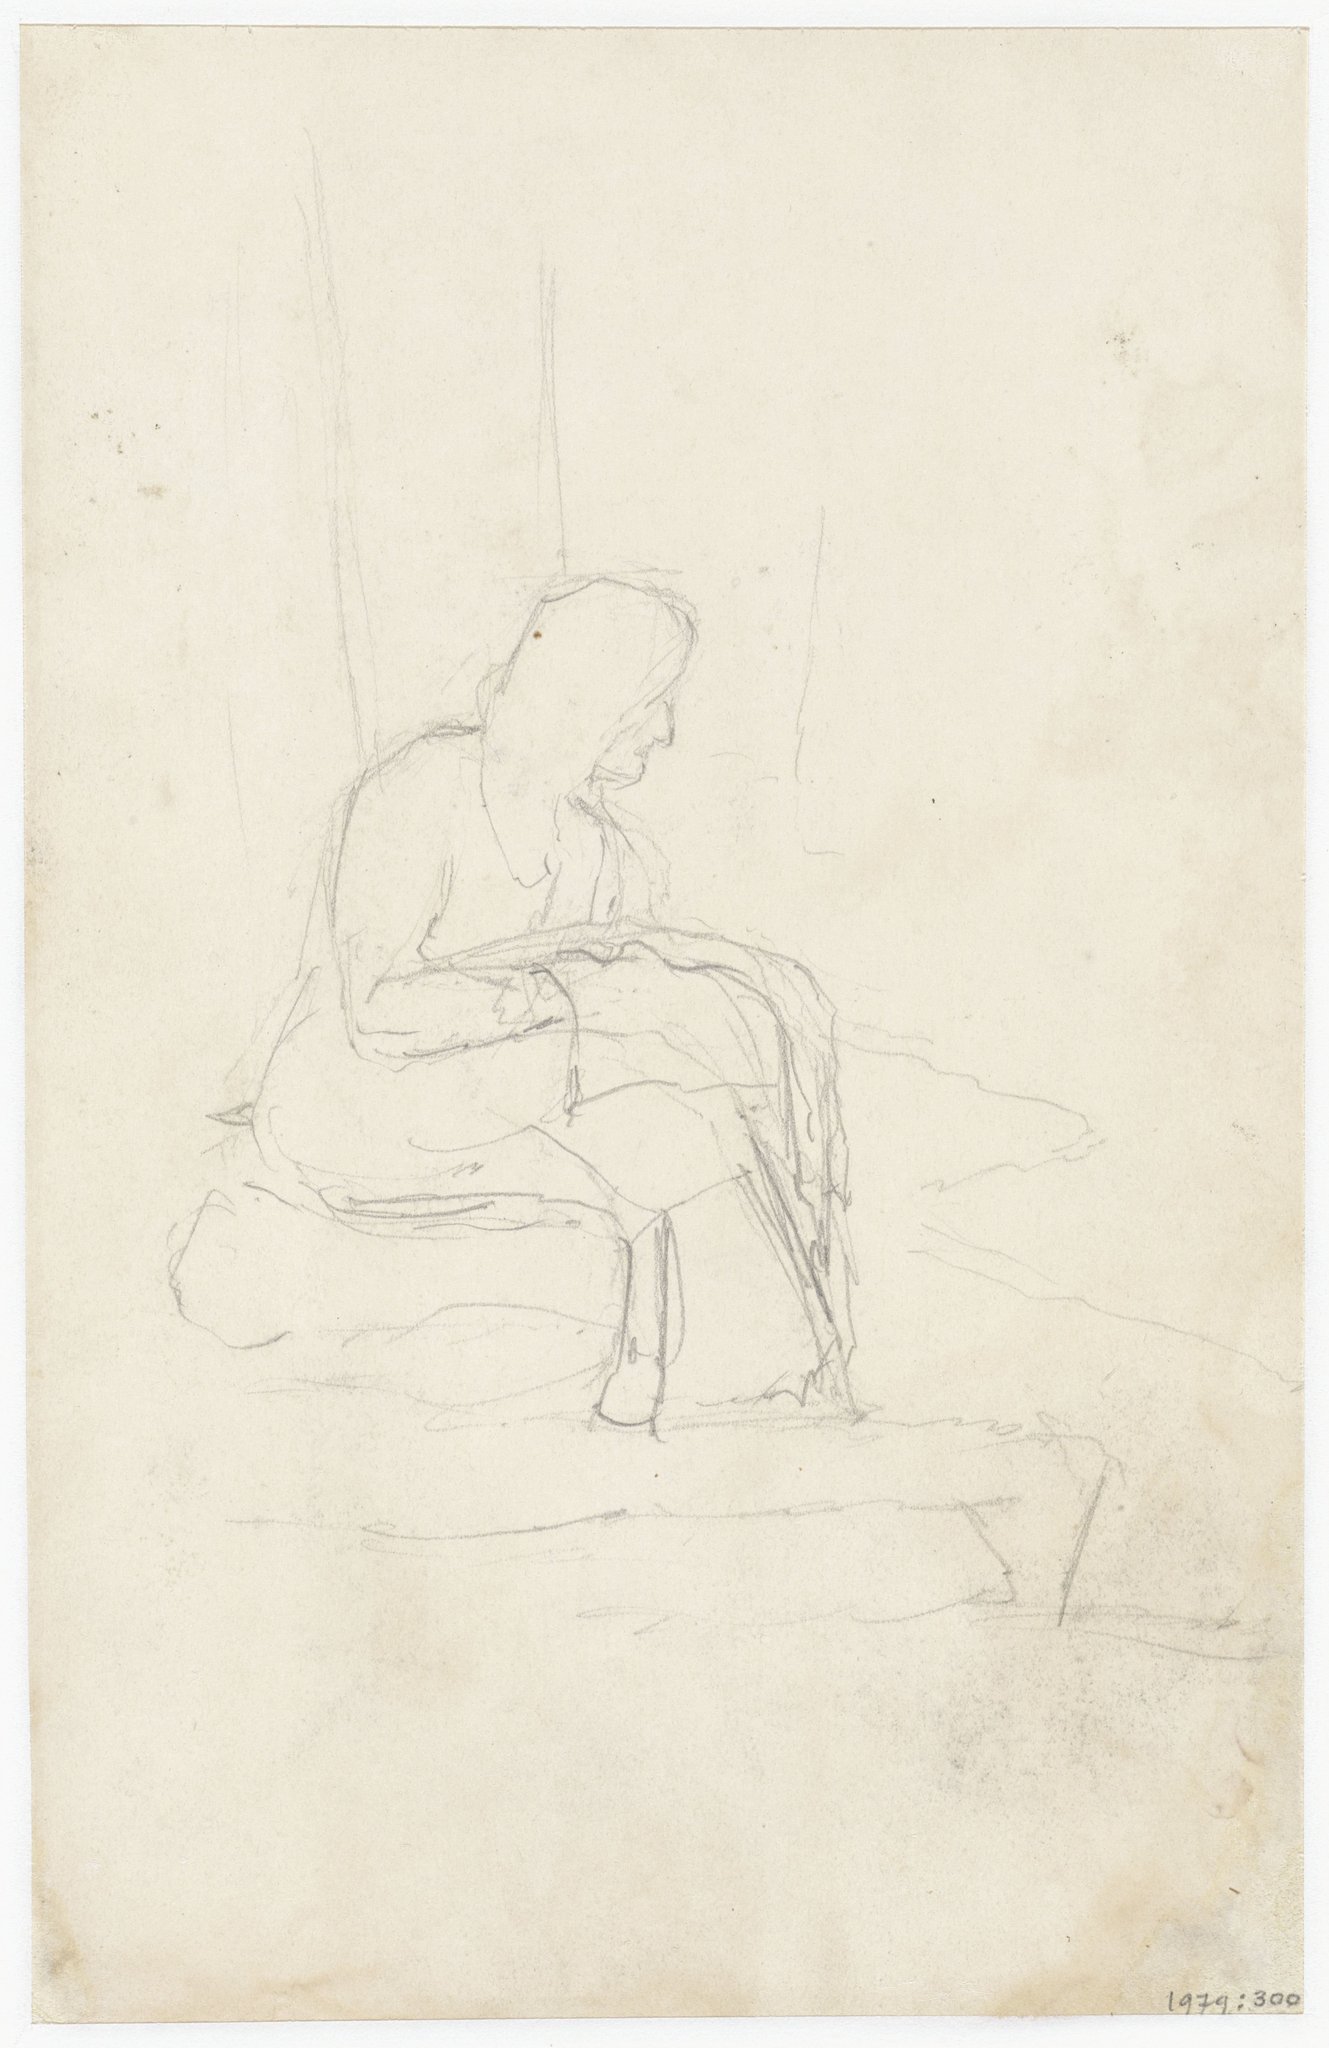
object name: drawing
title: Zittende figuur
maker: jozef israëls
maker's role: draughtsman, painter, print maker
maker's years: 1824-1911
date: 1834-1911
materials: paper, pencil